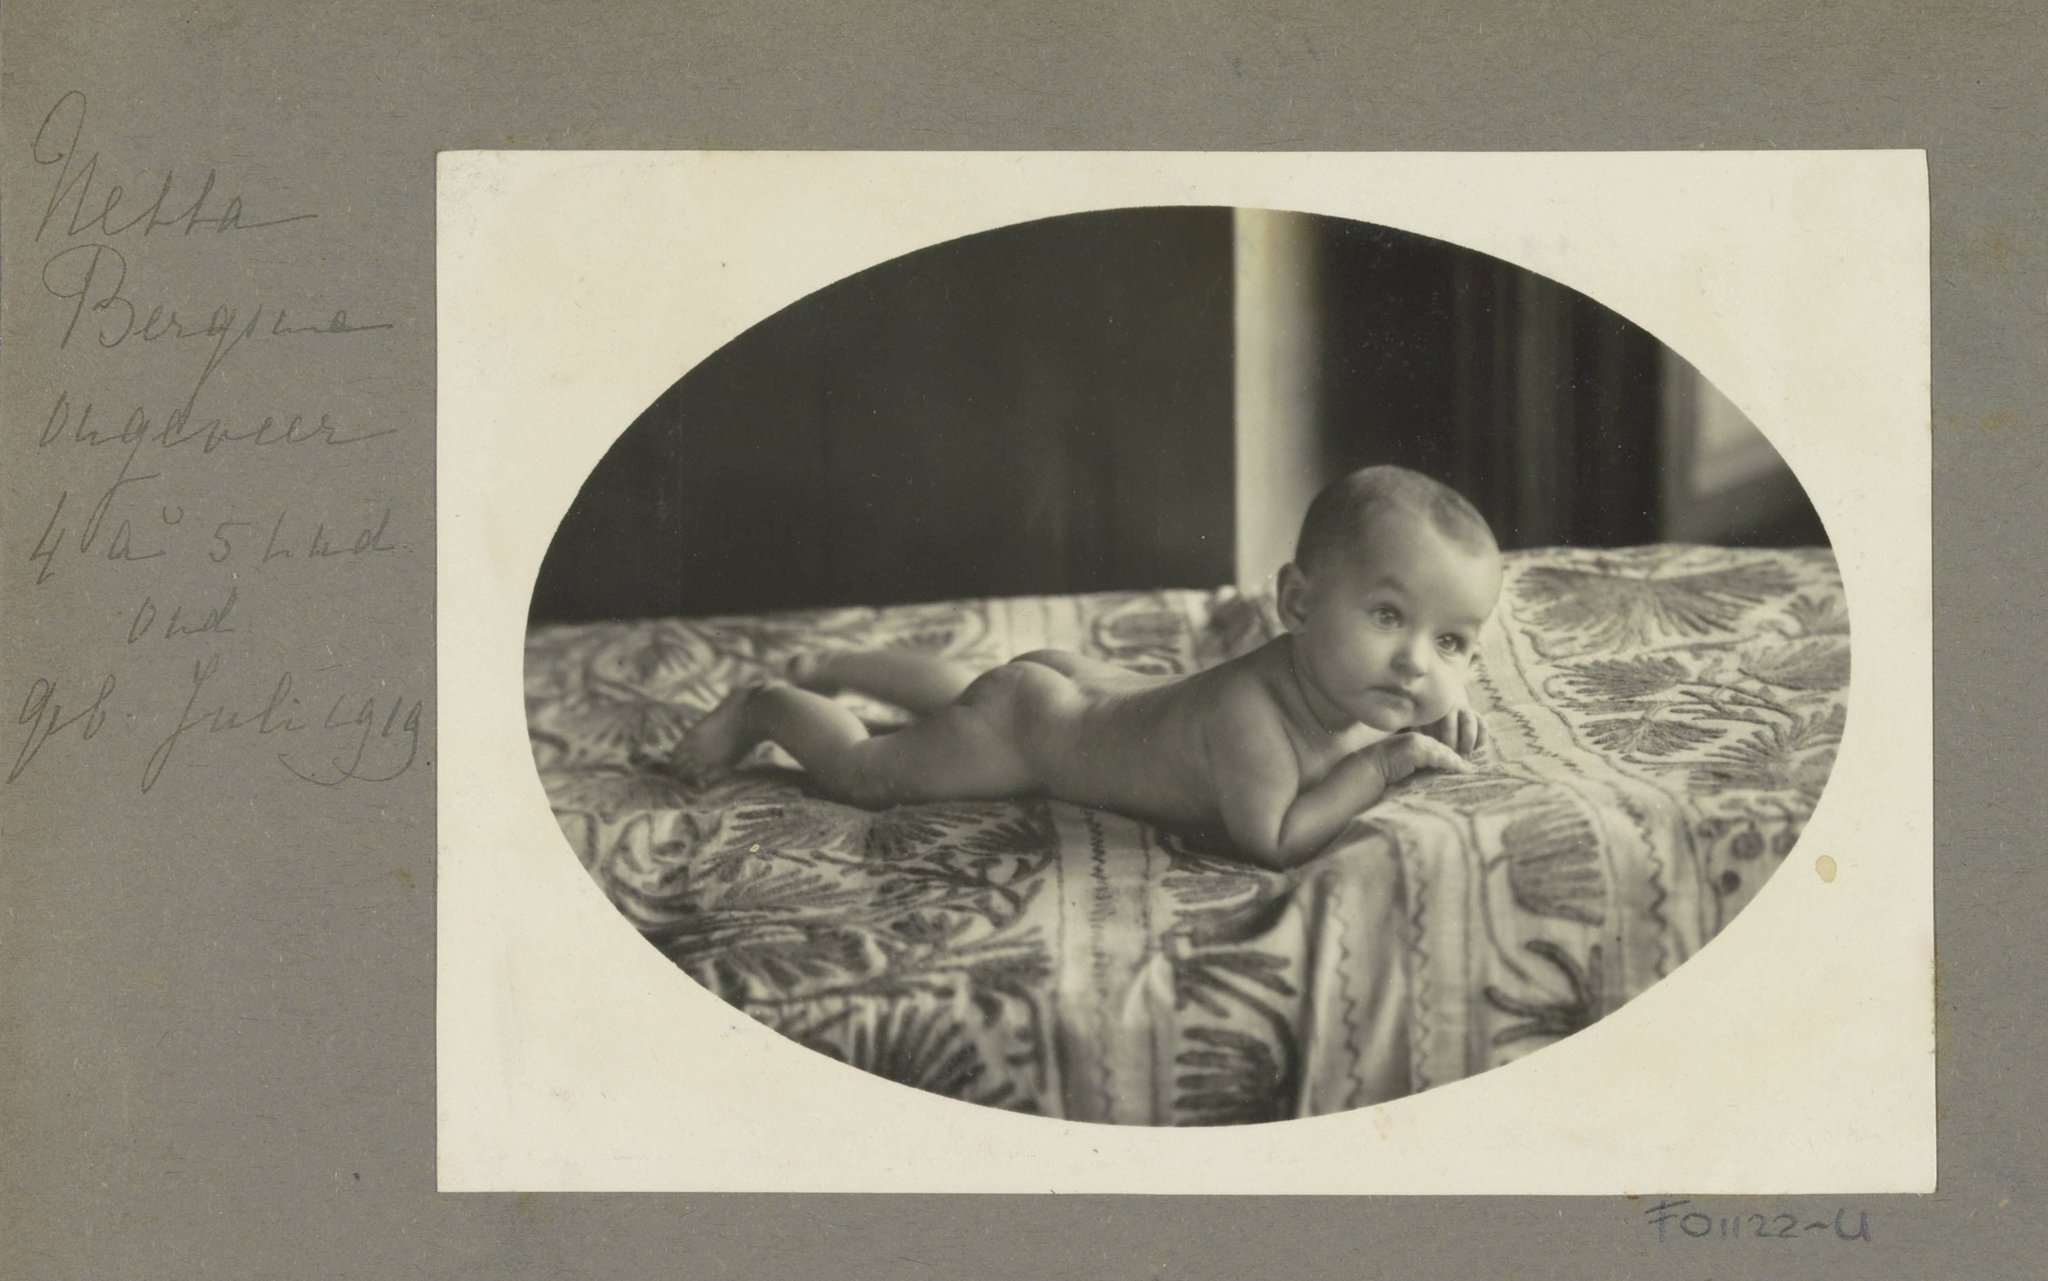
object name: photograph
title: Netta Bergsma als baby naakt op een kleed op Sumatra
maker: Anonymous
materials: photographic support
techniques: gelatin silver print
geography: sumatra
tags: infant, baby, sumatra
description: Onderdeel van fotoalbum met opnames van de familie Bergsma in Tandjong Poera en Rantan Pandjang (Sumatra).